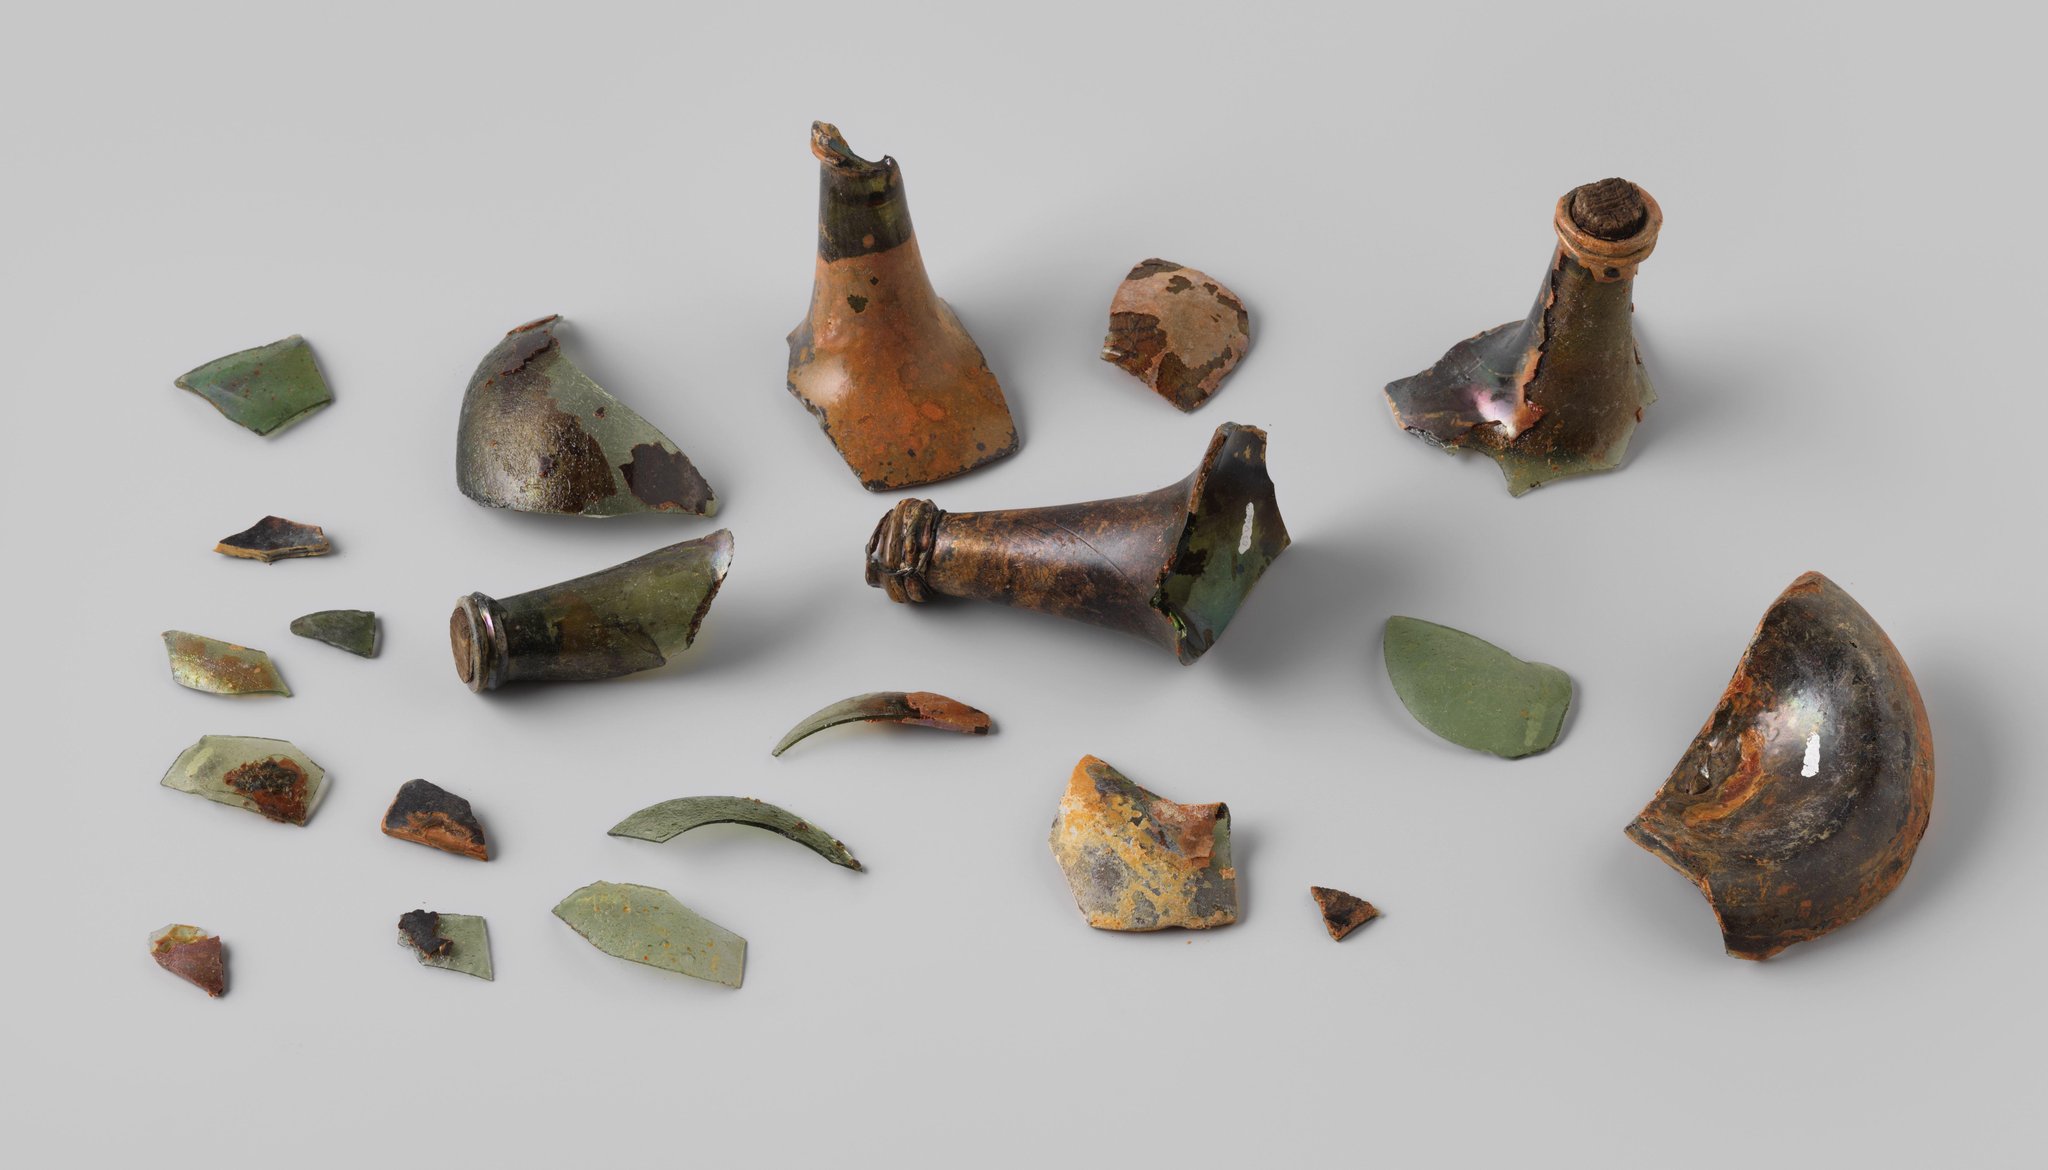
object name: sherd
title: Scherven van wijnflessen uit het wrak van de Oost-Indiëvaarder 't Vliegend Hart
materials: cork, glass, lacquer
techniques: green glass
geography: netherlands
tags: 't vliegend hart (schip), verenigde oostindische compagnie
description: Scherven van uivormige wijnflessen van groen glas waar rode (port)wijn in heeft gezeten. Halzen met kurk, waarvan één met ijzerdraad en lak.